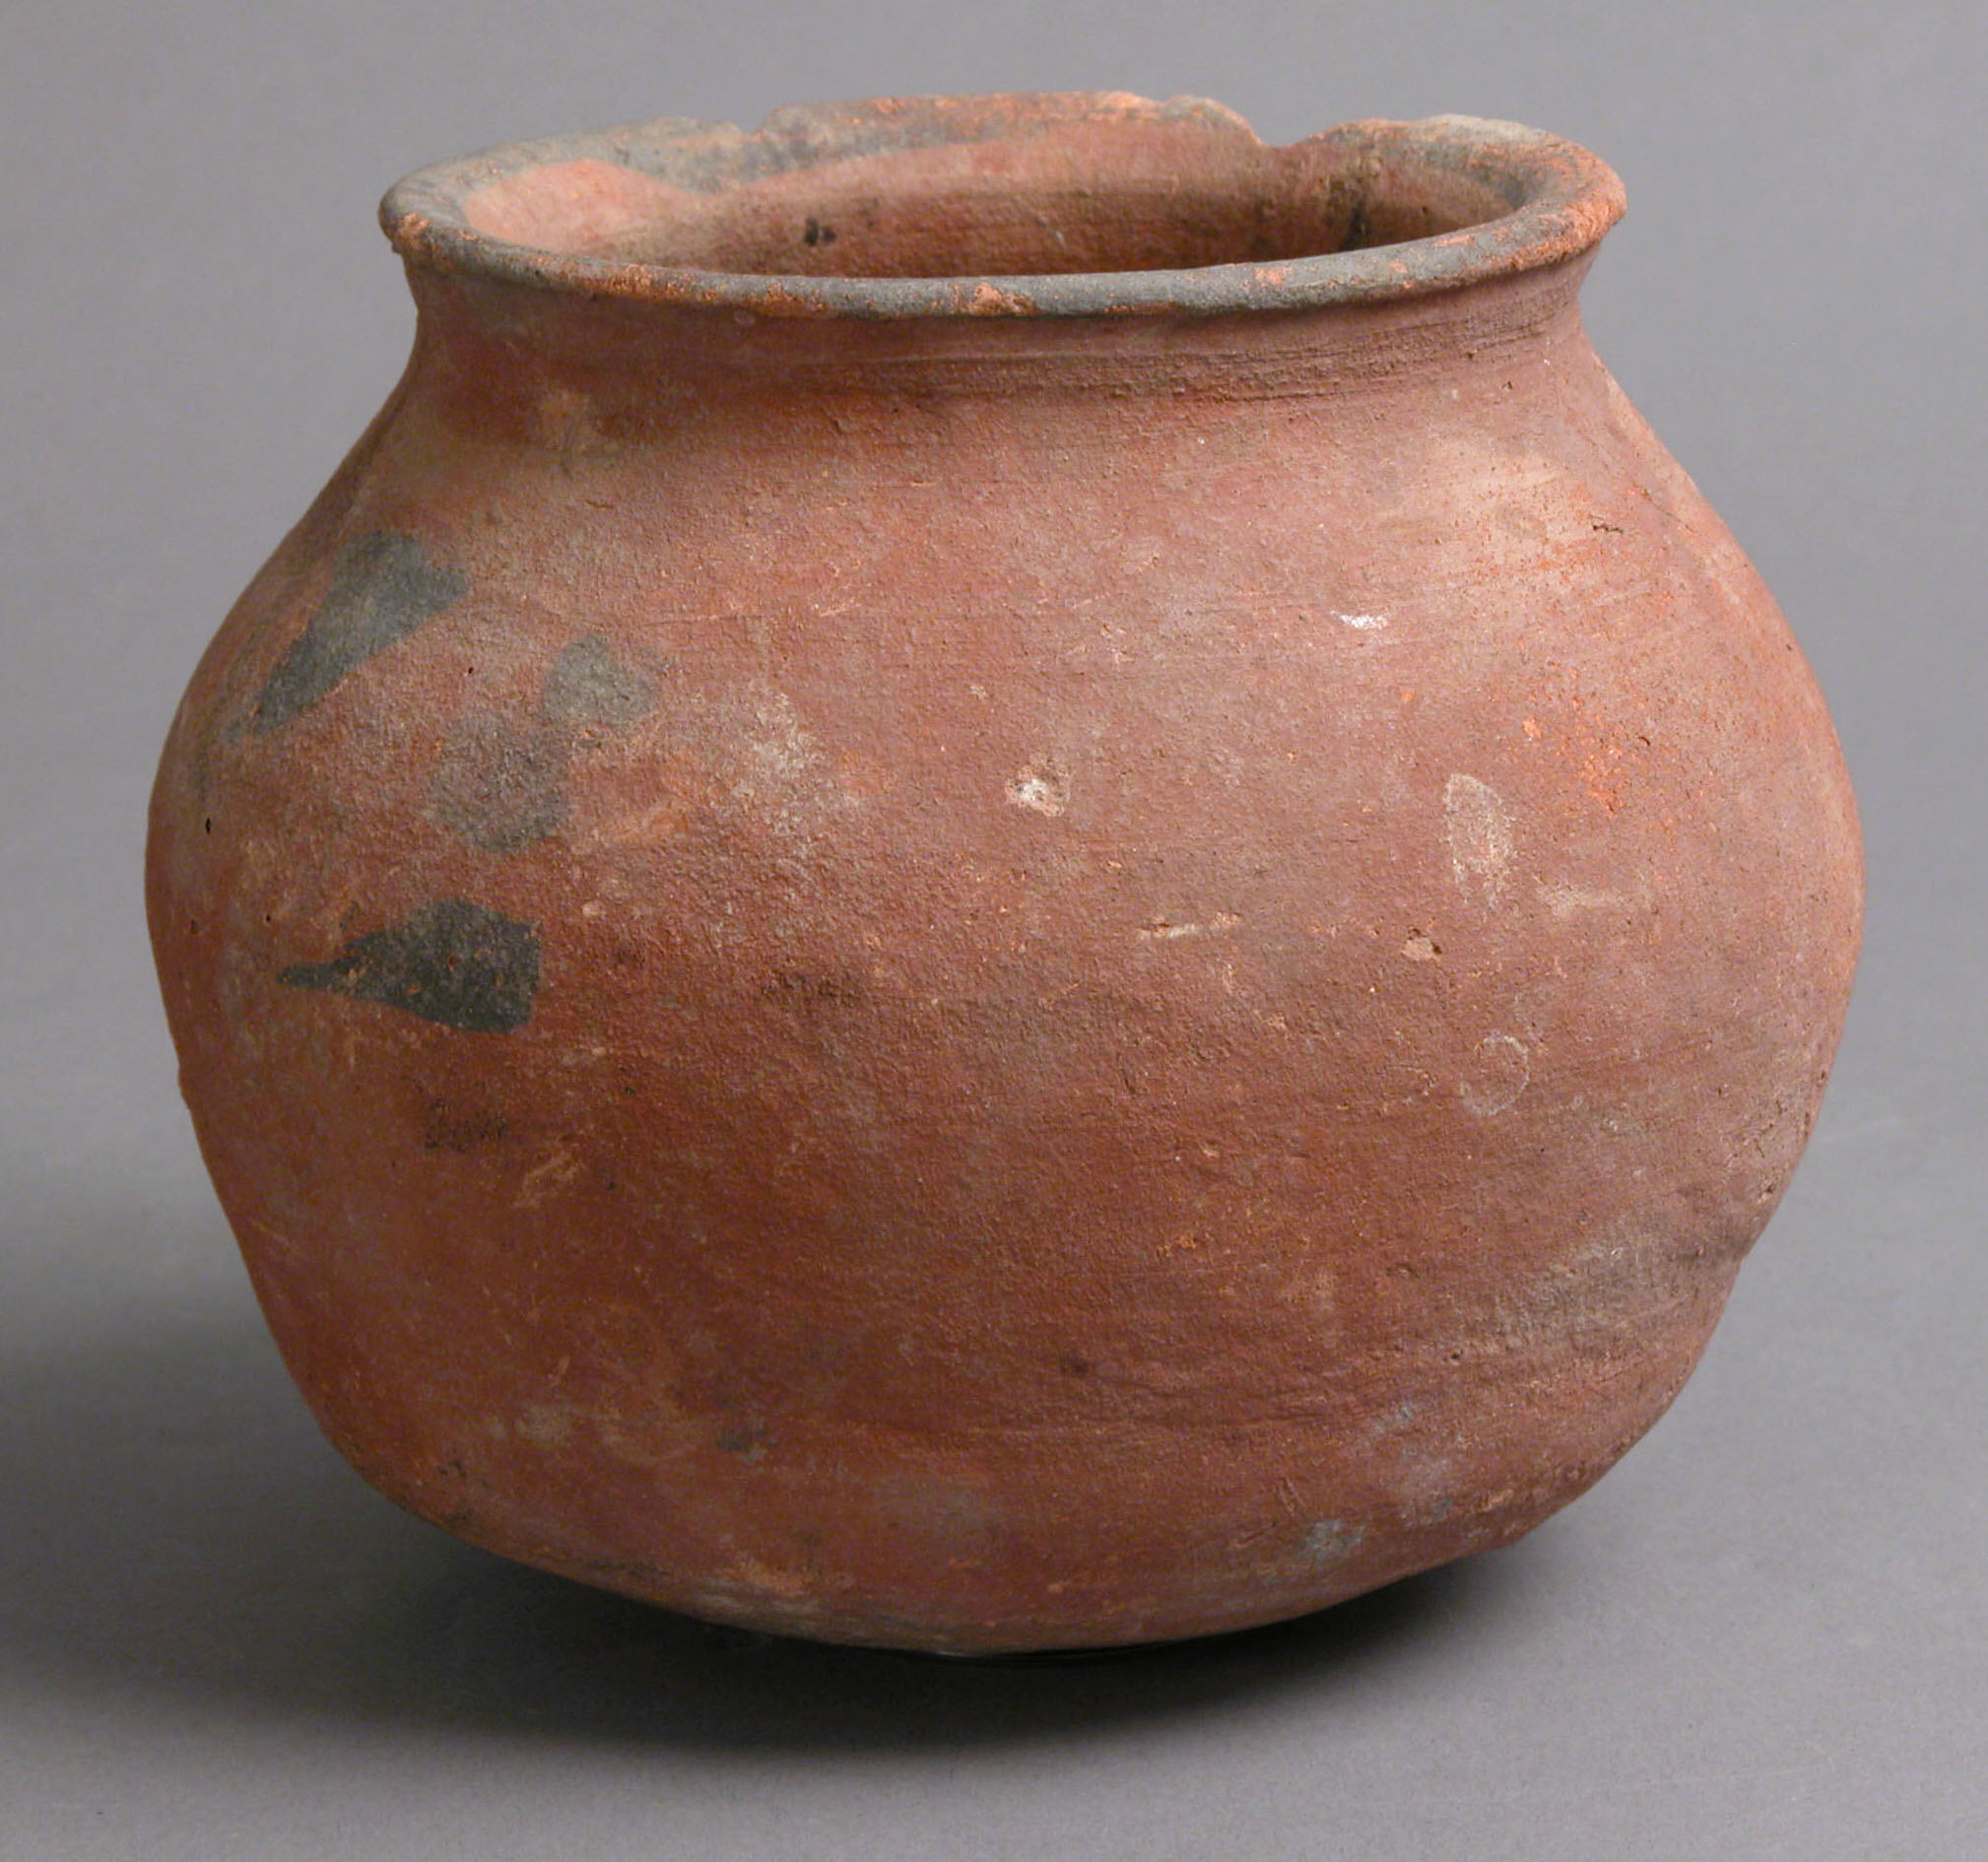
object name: pot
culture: coptic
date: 301-700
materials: earthenware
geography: egypt